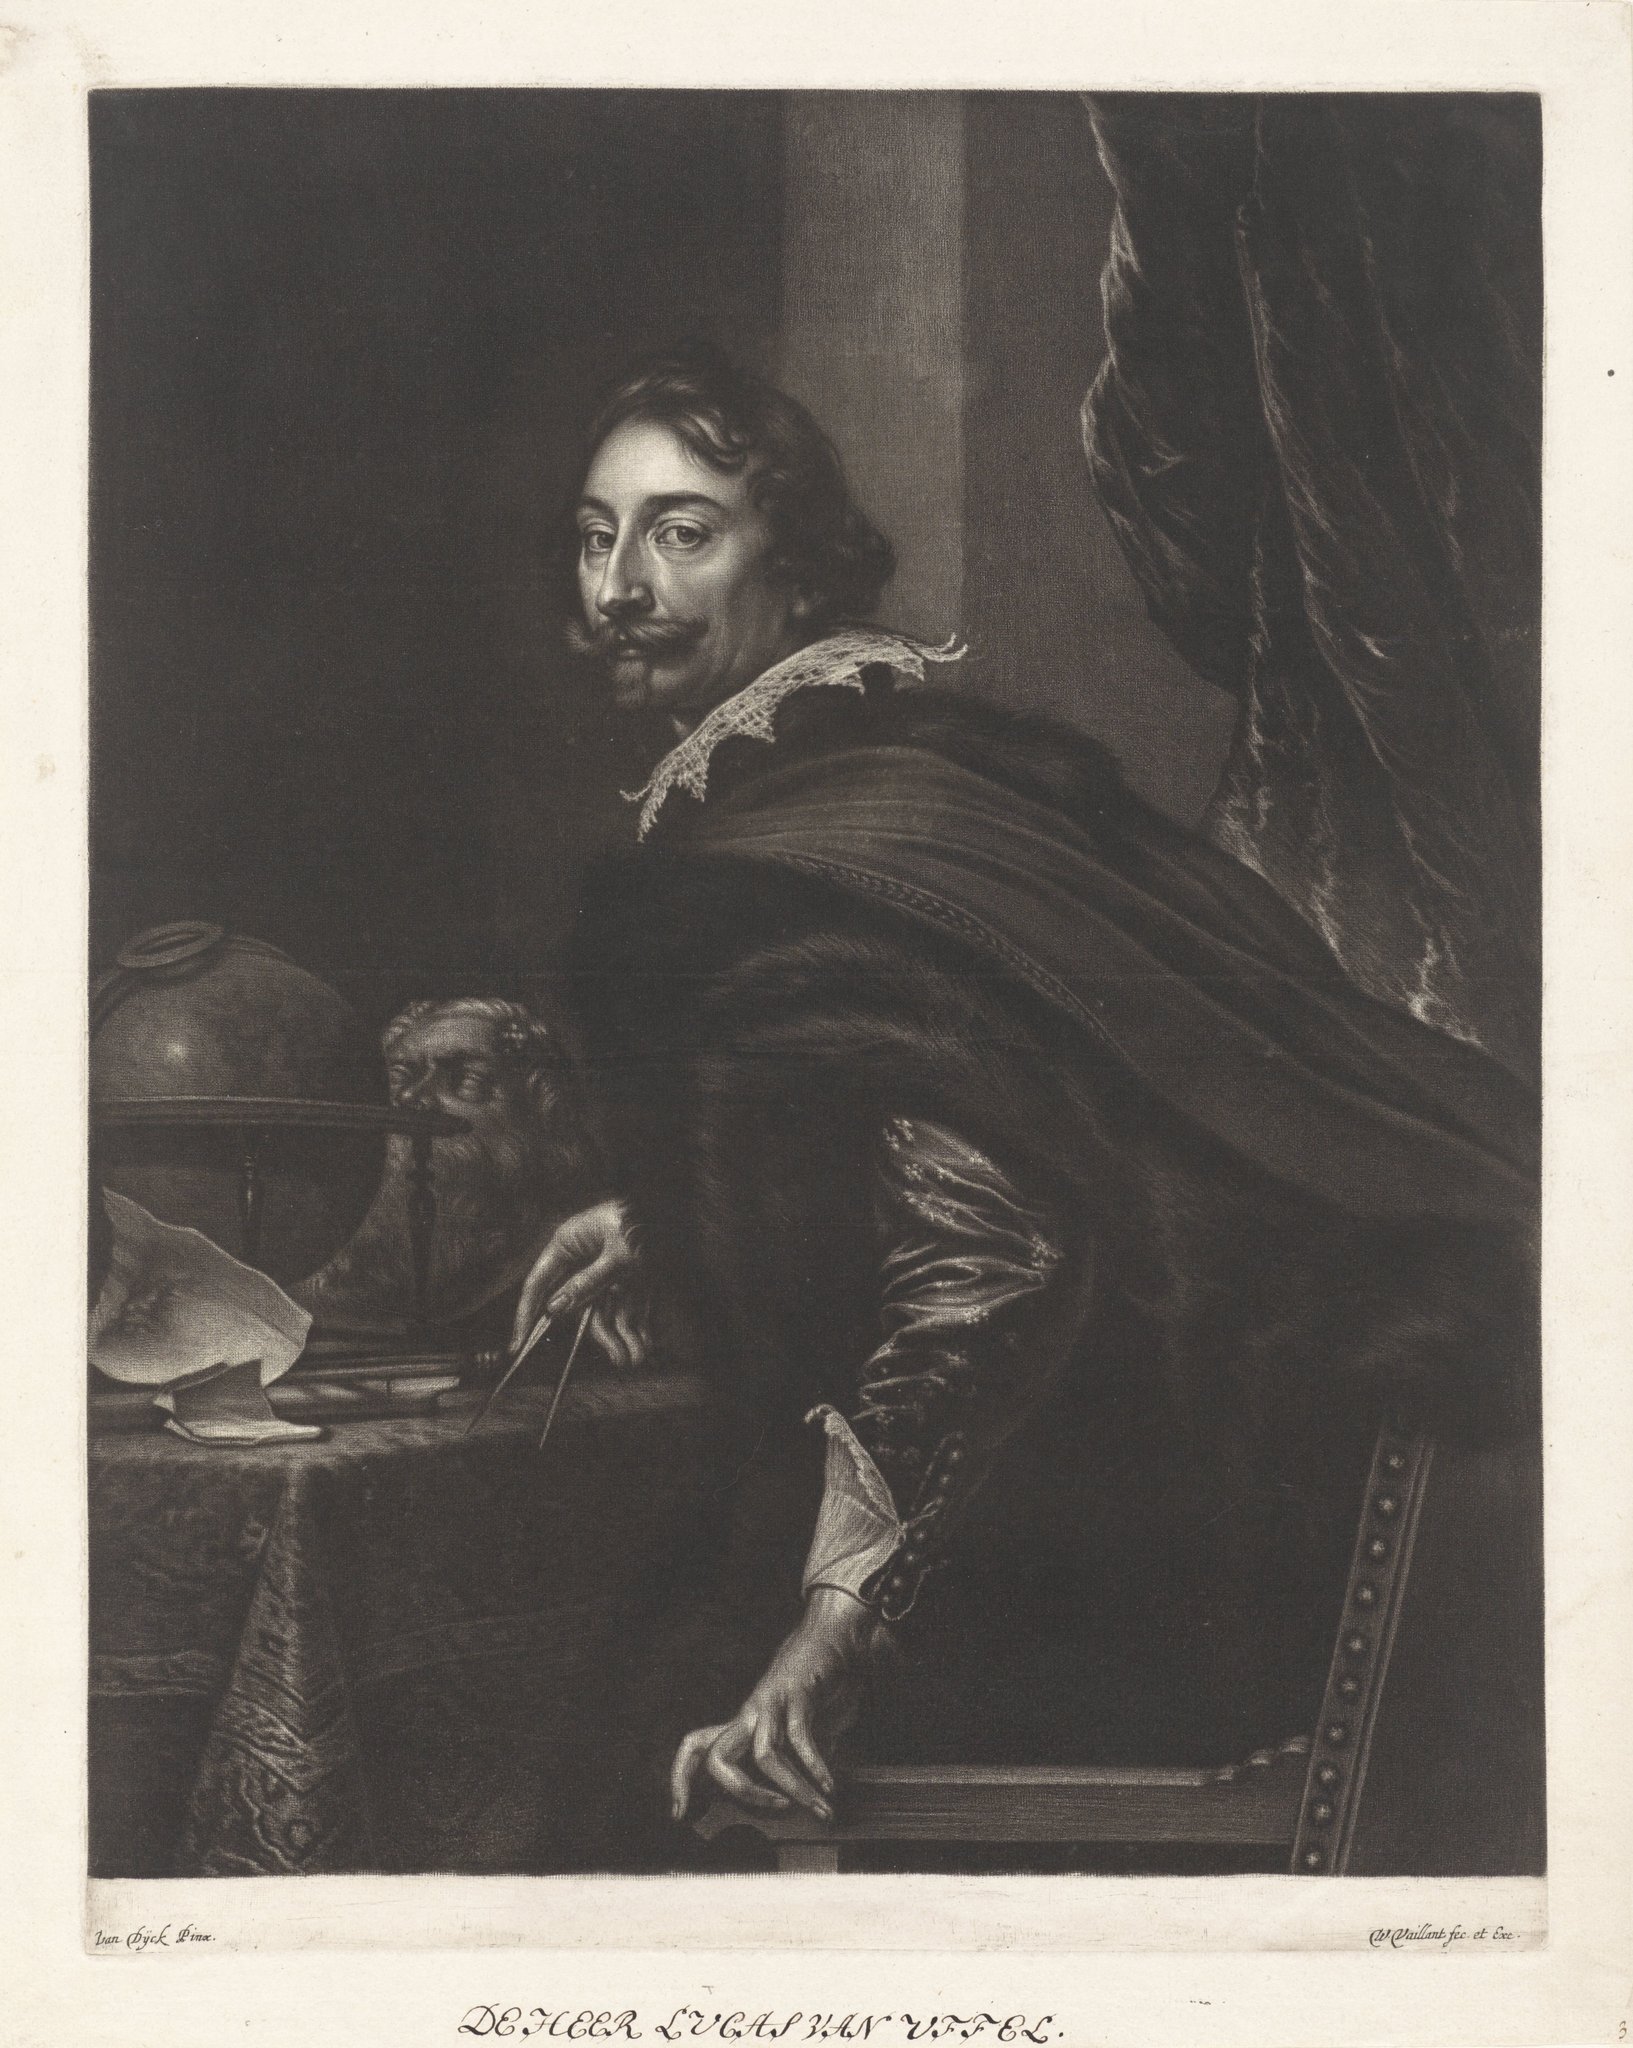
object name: print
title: Portret van Lucas van Uffel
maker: wallerant vaillant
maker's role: draughtsman, painter, print maker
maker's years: 1623-1677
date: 1658-1677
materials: paper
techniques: mezzotint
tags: lucas van uffel, compasses, piece of sculpture, reproduction of a piece of sculpture, globe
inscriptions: inscription: ‘De Heer Lucas van Uffel’, collector's mark: Lugt 240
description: De koopman, reder en verzamelaar Lucas van Uffel staat op uit zijn stoel. In zijn hand een passer. Op de tafel liggen attributen die zijn brede interesse etaleert; een klassieke kop, een hemelbol, een tekening, een fluit en de strijkstok van een viola da gamba.